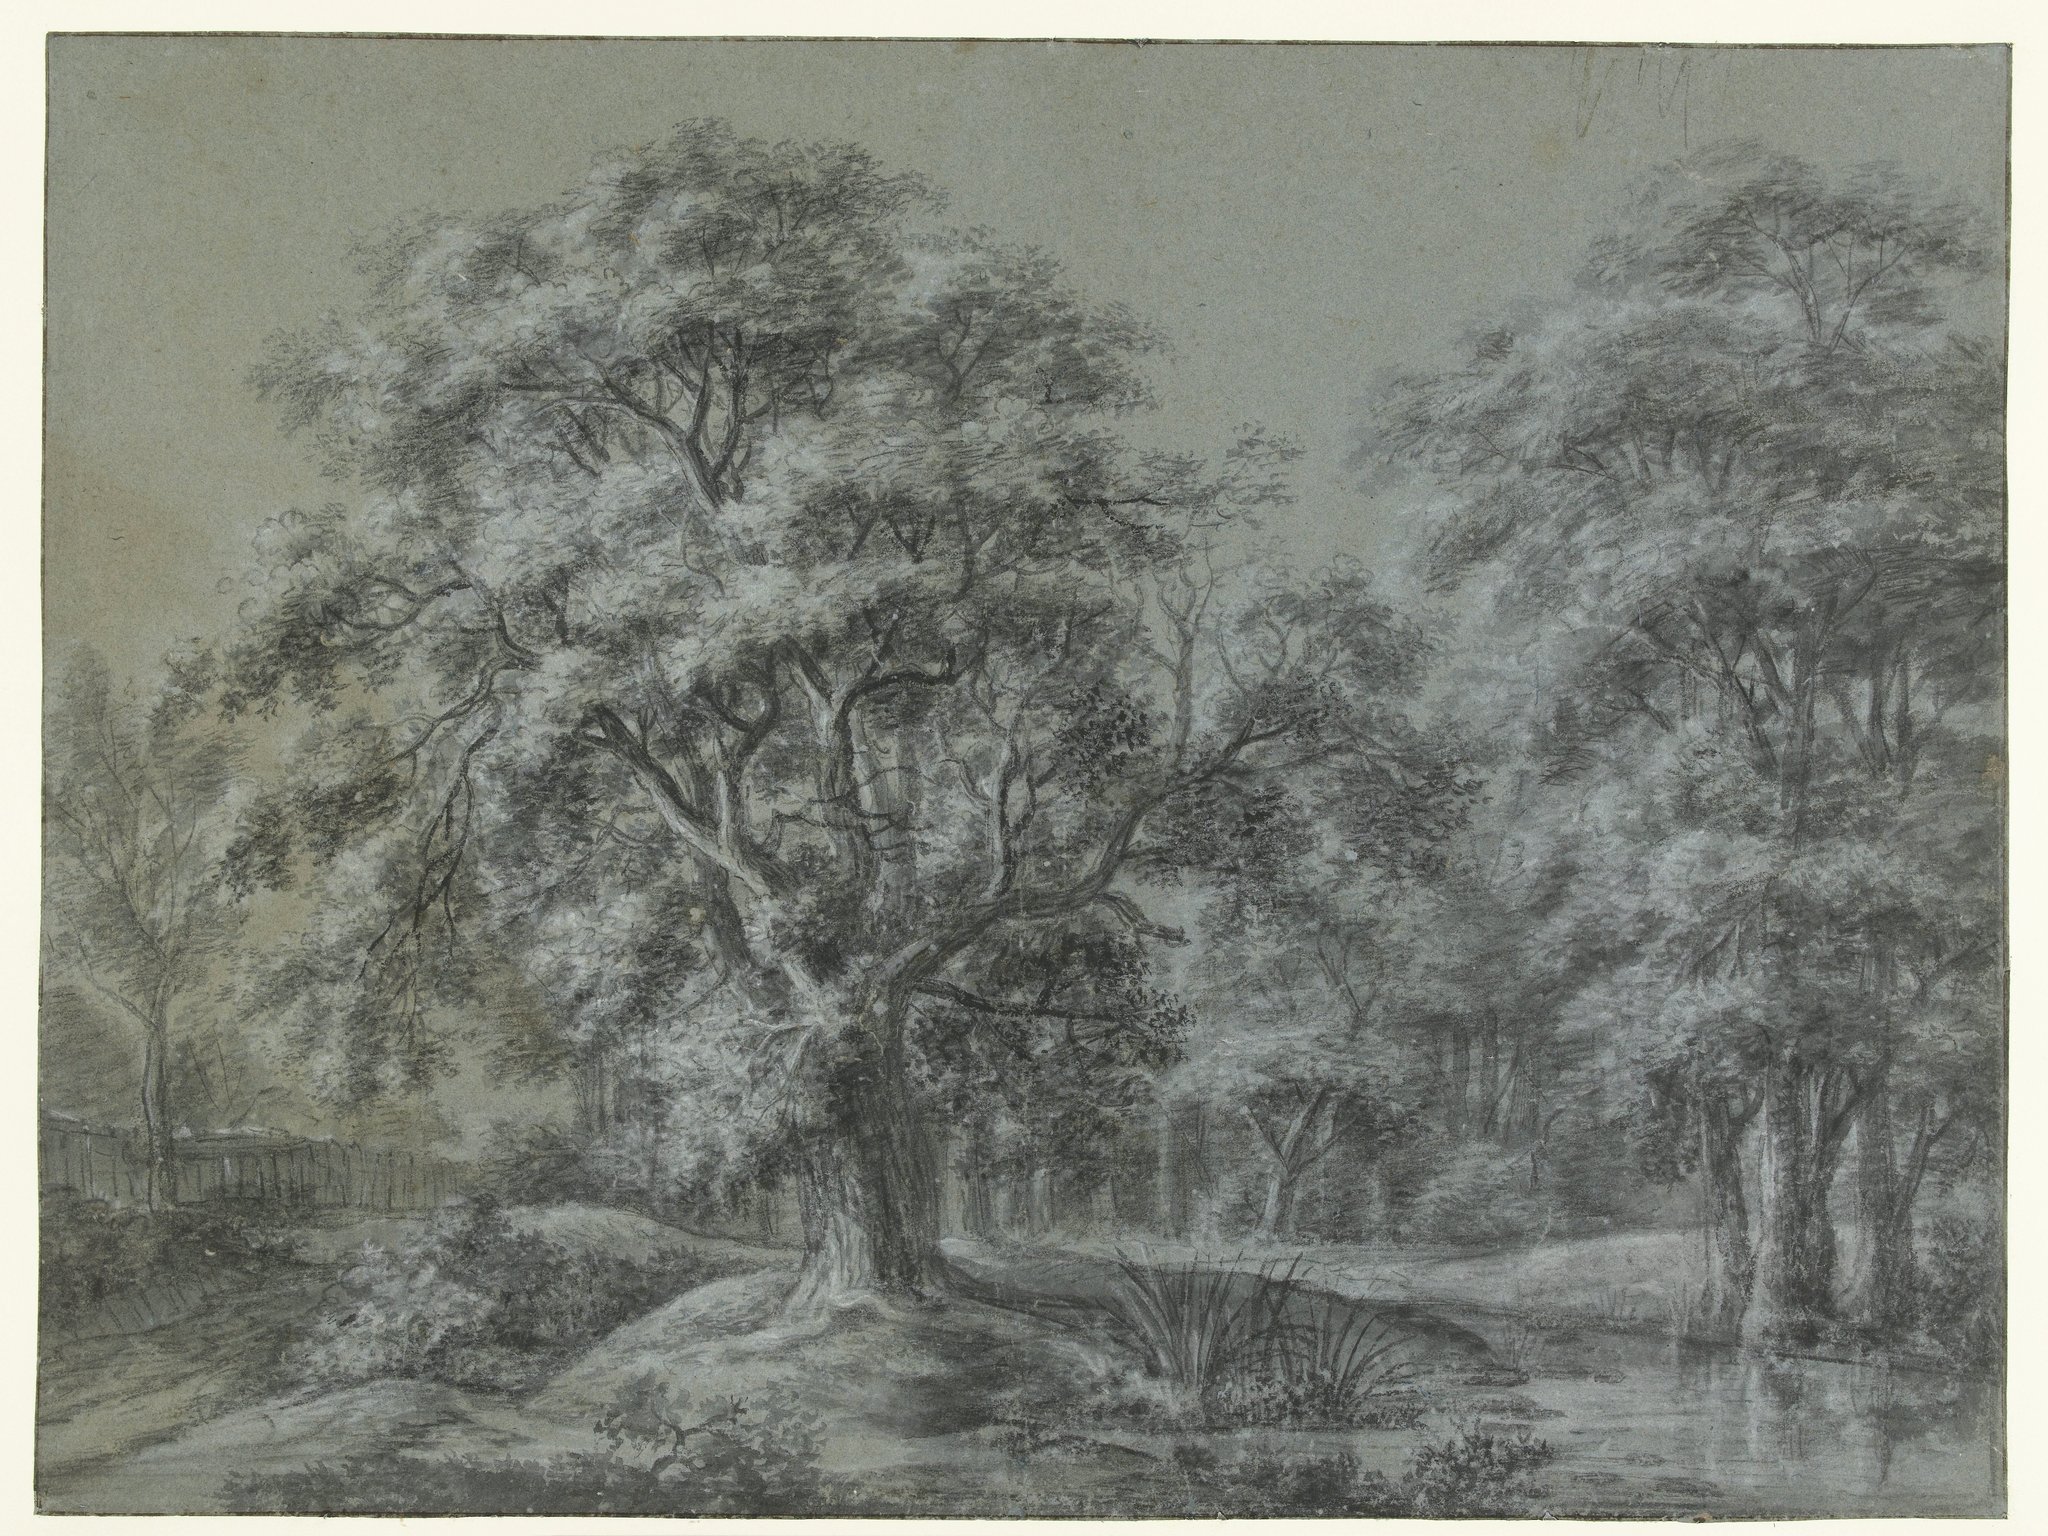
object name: drawing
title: Boslandschap met een water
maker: simon de vlieger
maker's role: draughtsman, painter, print maker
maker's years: 1600-1653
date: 1610-1653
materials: chalk, paper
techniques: brush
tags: forest, wood